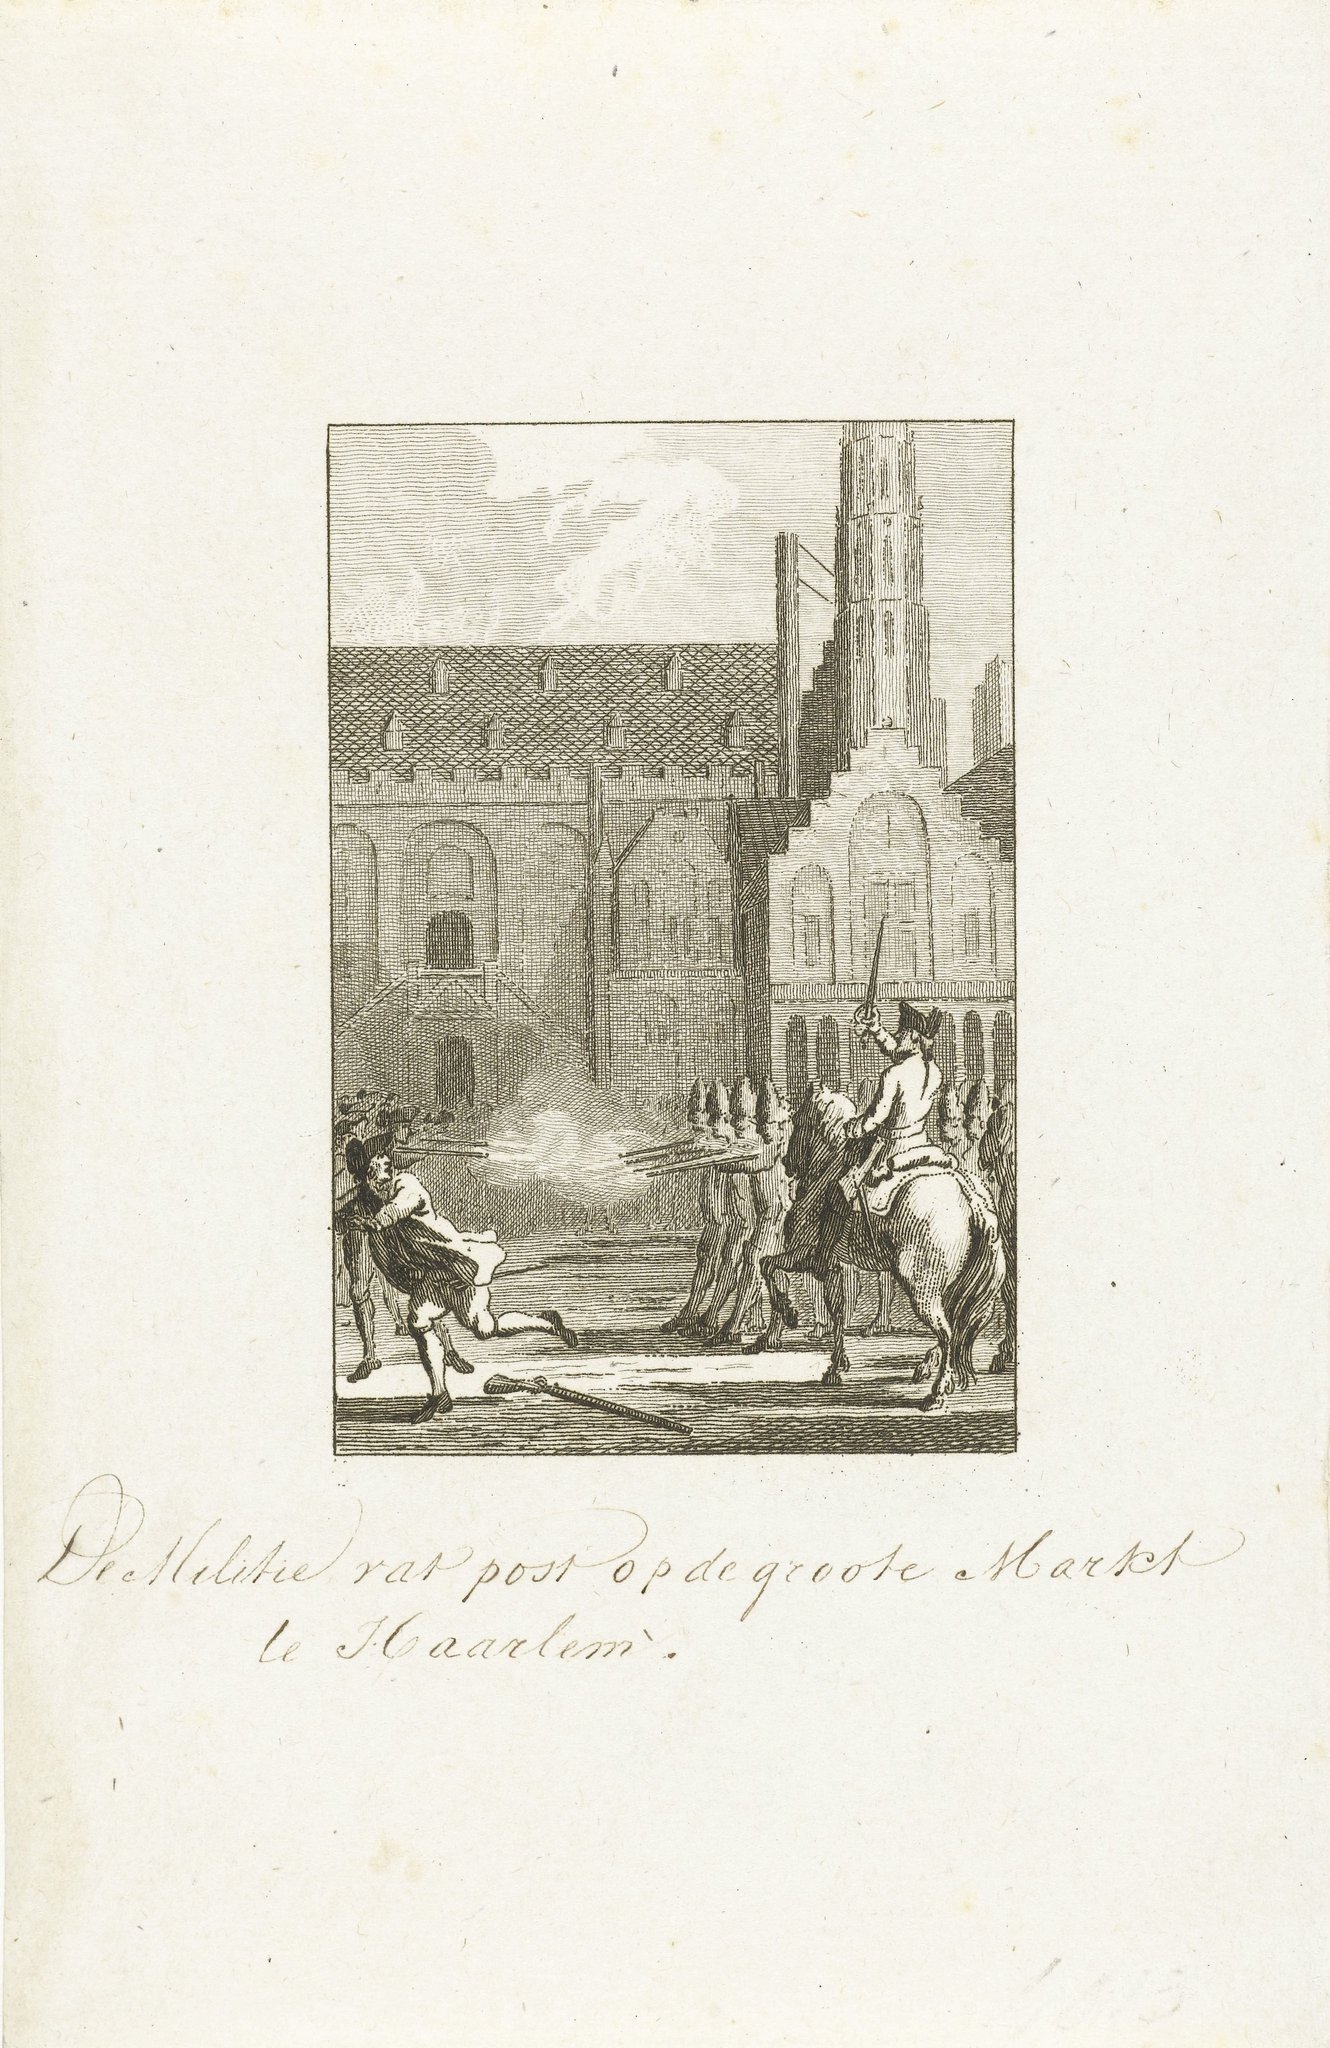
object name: print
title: Militie vuurt op de oproerigen te Haarlem, 1750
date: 1788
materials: paper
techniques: etching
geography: northern netherlands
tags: anti-riot measures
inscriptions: inscription: ‘De Militie vat post op de groote Markt te Haarlem’, collector's mark: Lugt 2228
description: Gebruikt als illustratie in: J. Fokke, Geschiedenissen der Vereenigde Nederlanden voor de vaderlandsche jeugd, Johannes Allart, Amsterdam 1783-1795, 25 delen, dl. 11, afb. 11.